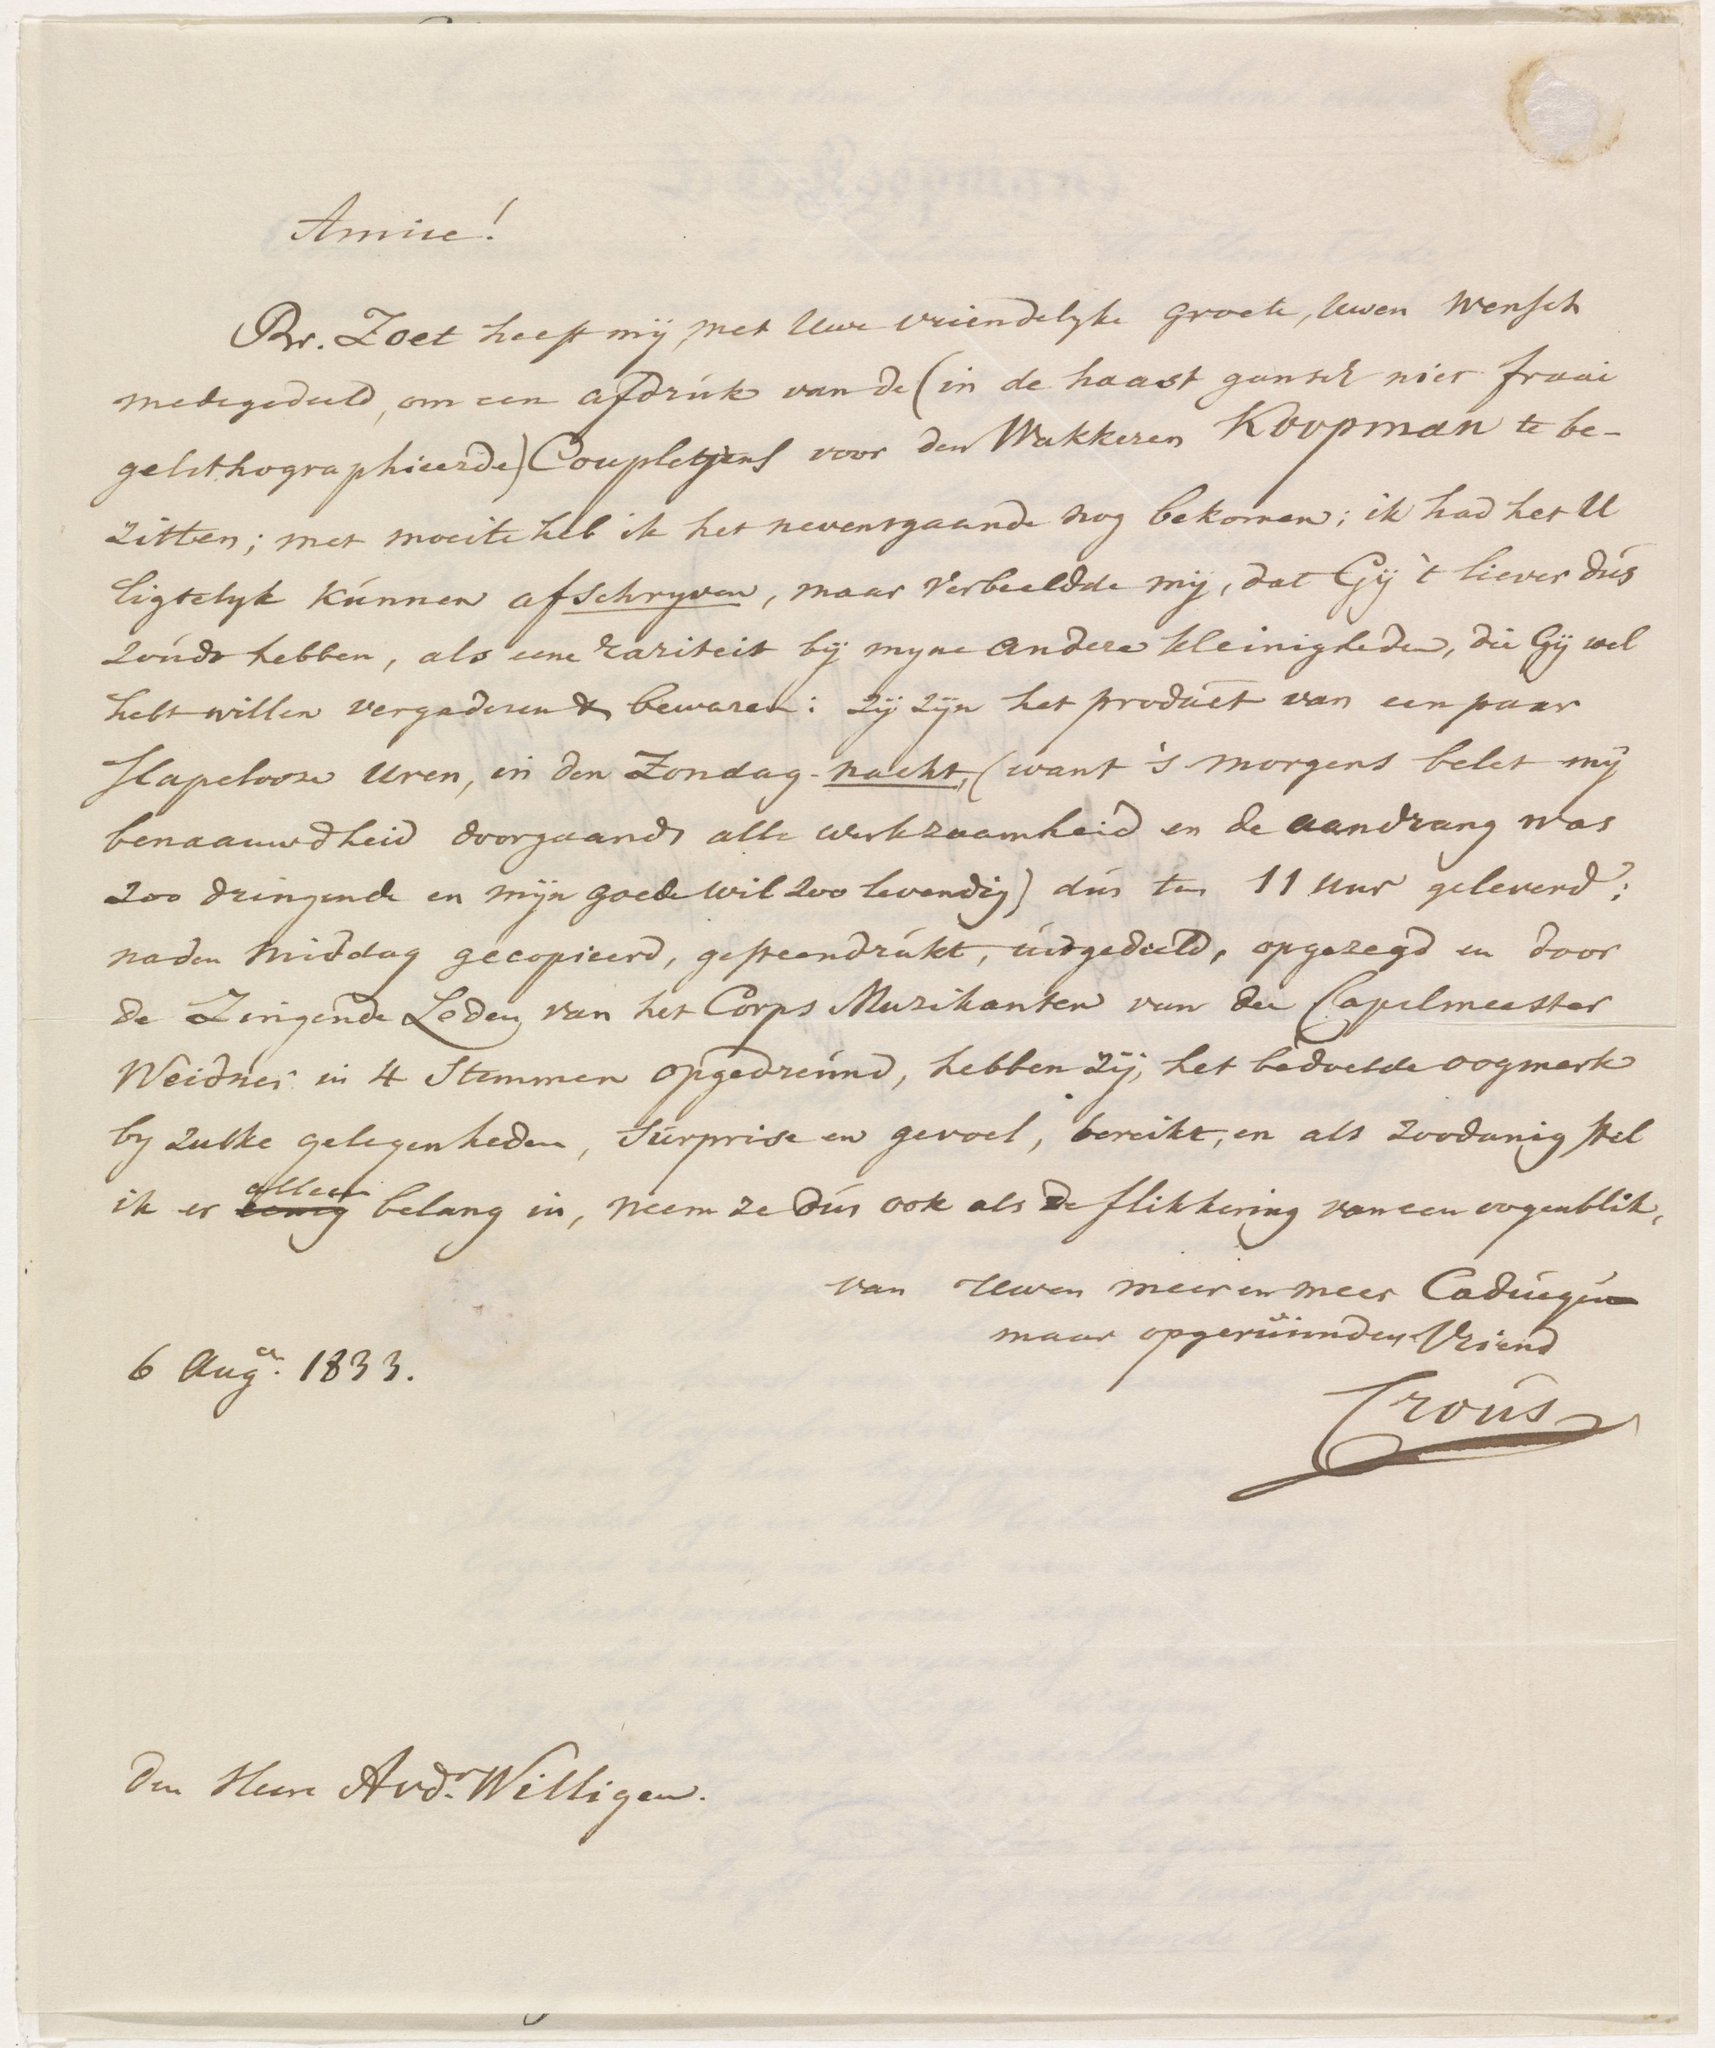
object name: manuscript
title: Afschrift van het lied ter ere van luitenant Koopman en begeleidend schrijven, 1833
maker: Anonymous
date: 1833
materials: paper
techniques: writing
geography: netherlands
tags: utrecht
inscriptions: collector's mark: Lugt 2228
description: Afschrift van het lied ter ere van luitenant Jan Coenraad Koopman, uit Haarlem, en de zijn heldendaden, onder andere tijdens de Tweede expeditie naar Palembang op 24 juni 1821. Lied gecomponeerd in 1833, mogelijk tgv het toekennen van de Militaire Willemsorde aan Koopman. Hierbij ook een brief van 'Crous' aan de heer A. v.d. Willegen inzake het afschrift van het lied, gedateerd 6 augustus 1833.